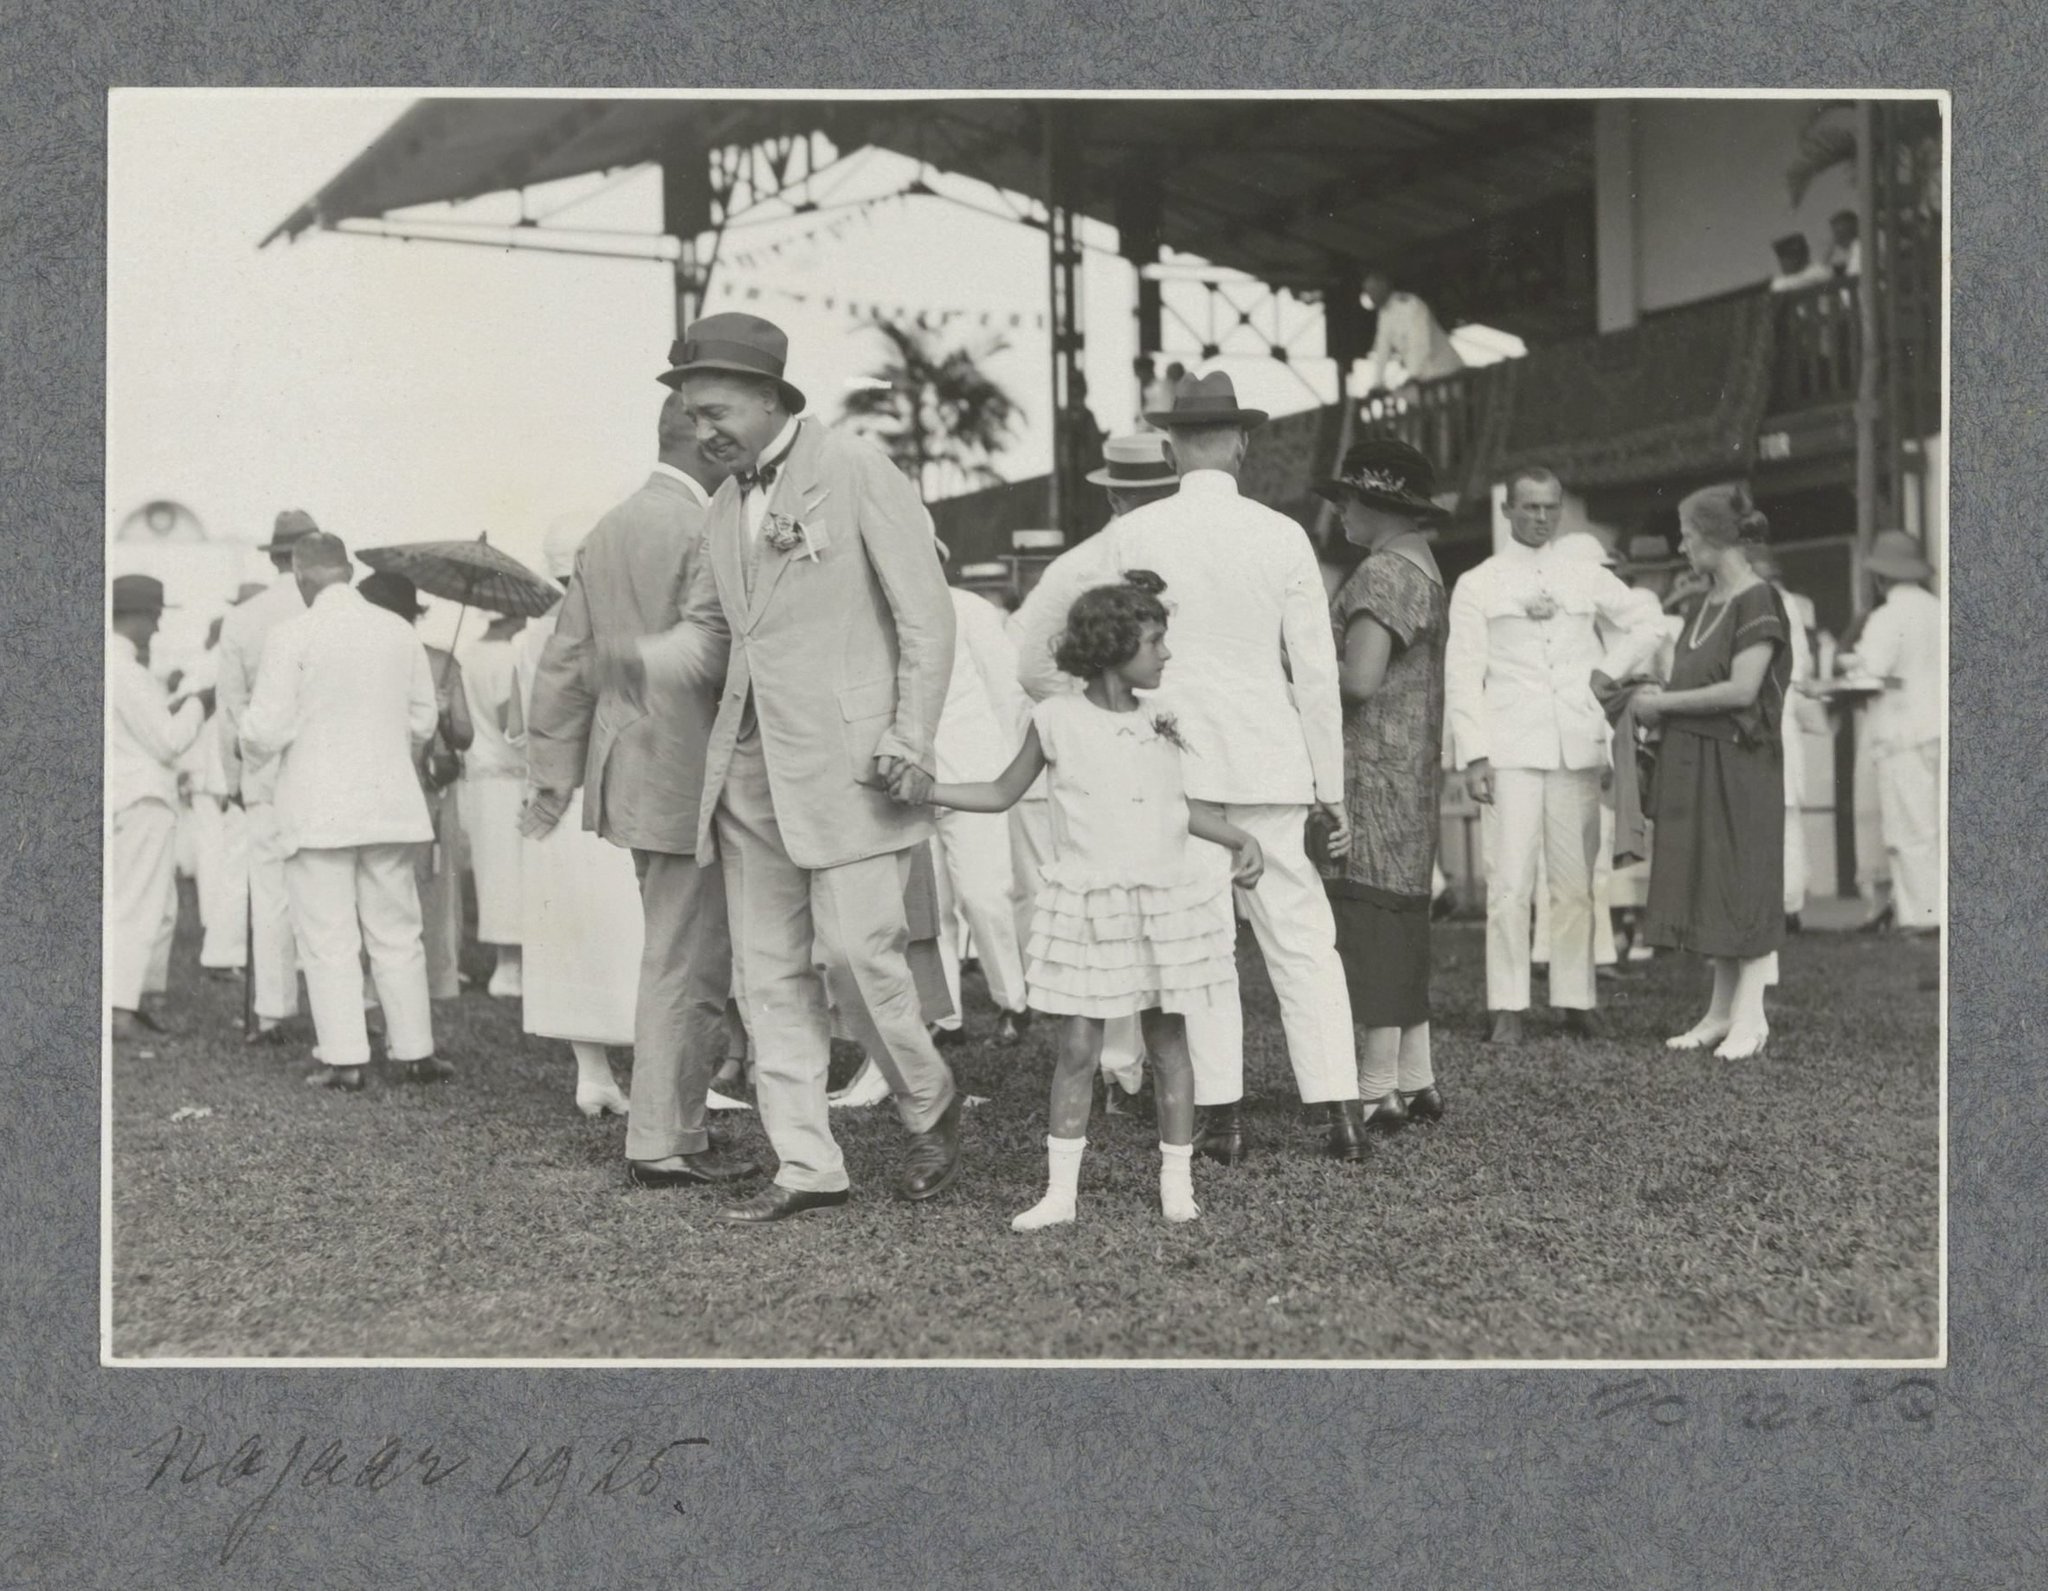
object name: photograph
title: Man met kind op Sumatra, mogelijk Eiso Bergsma en zijn dochter Netta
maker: Anonymous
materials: photographic support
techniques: gelatin silver print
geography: sumatra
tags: father and child(ren), man and child(ren) (family group), sumatra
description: Onderdeel van fotoalbum met opnames van de familie Bergsma in Tandjong Poera en Rantan Pandjang (Sumatra).